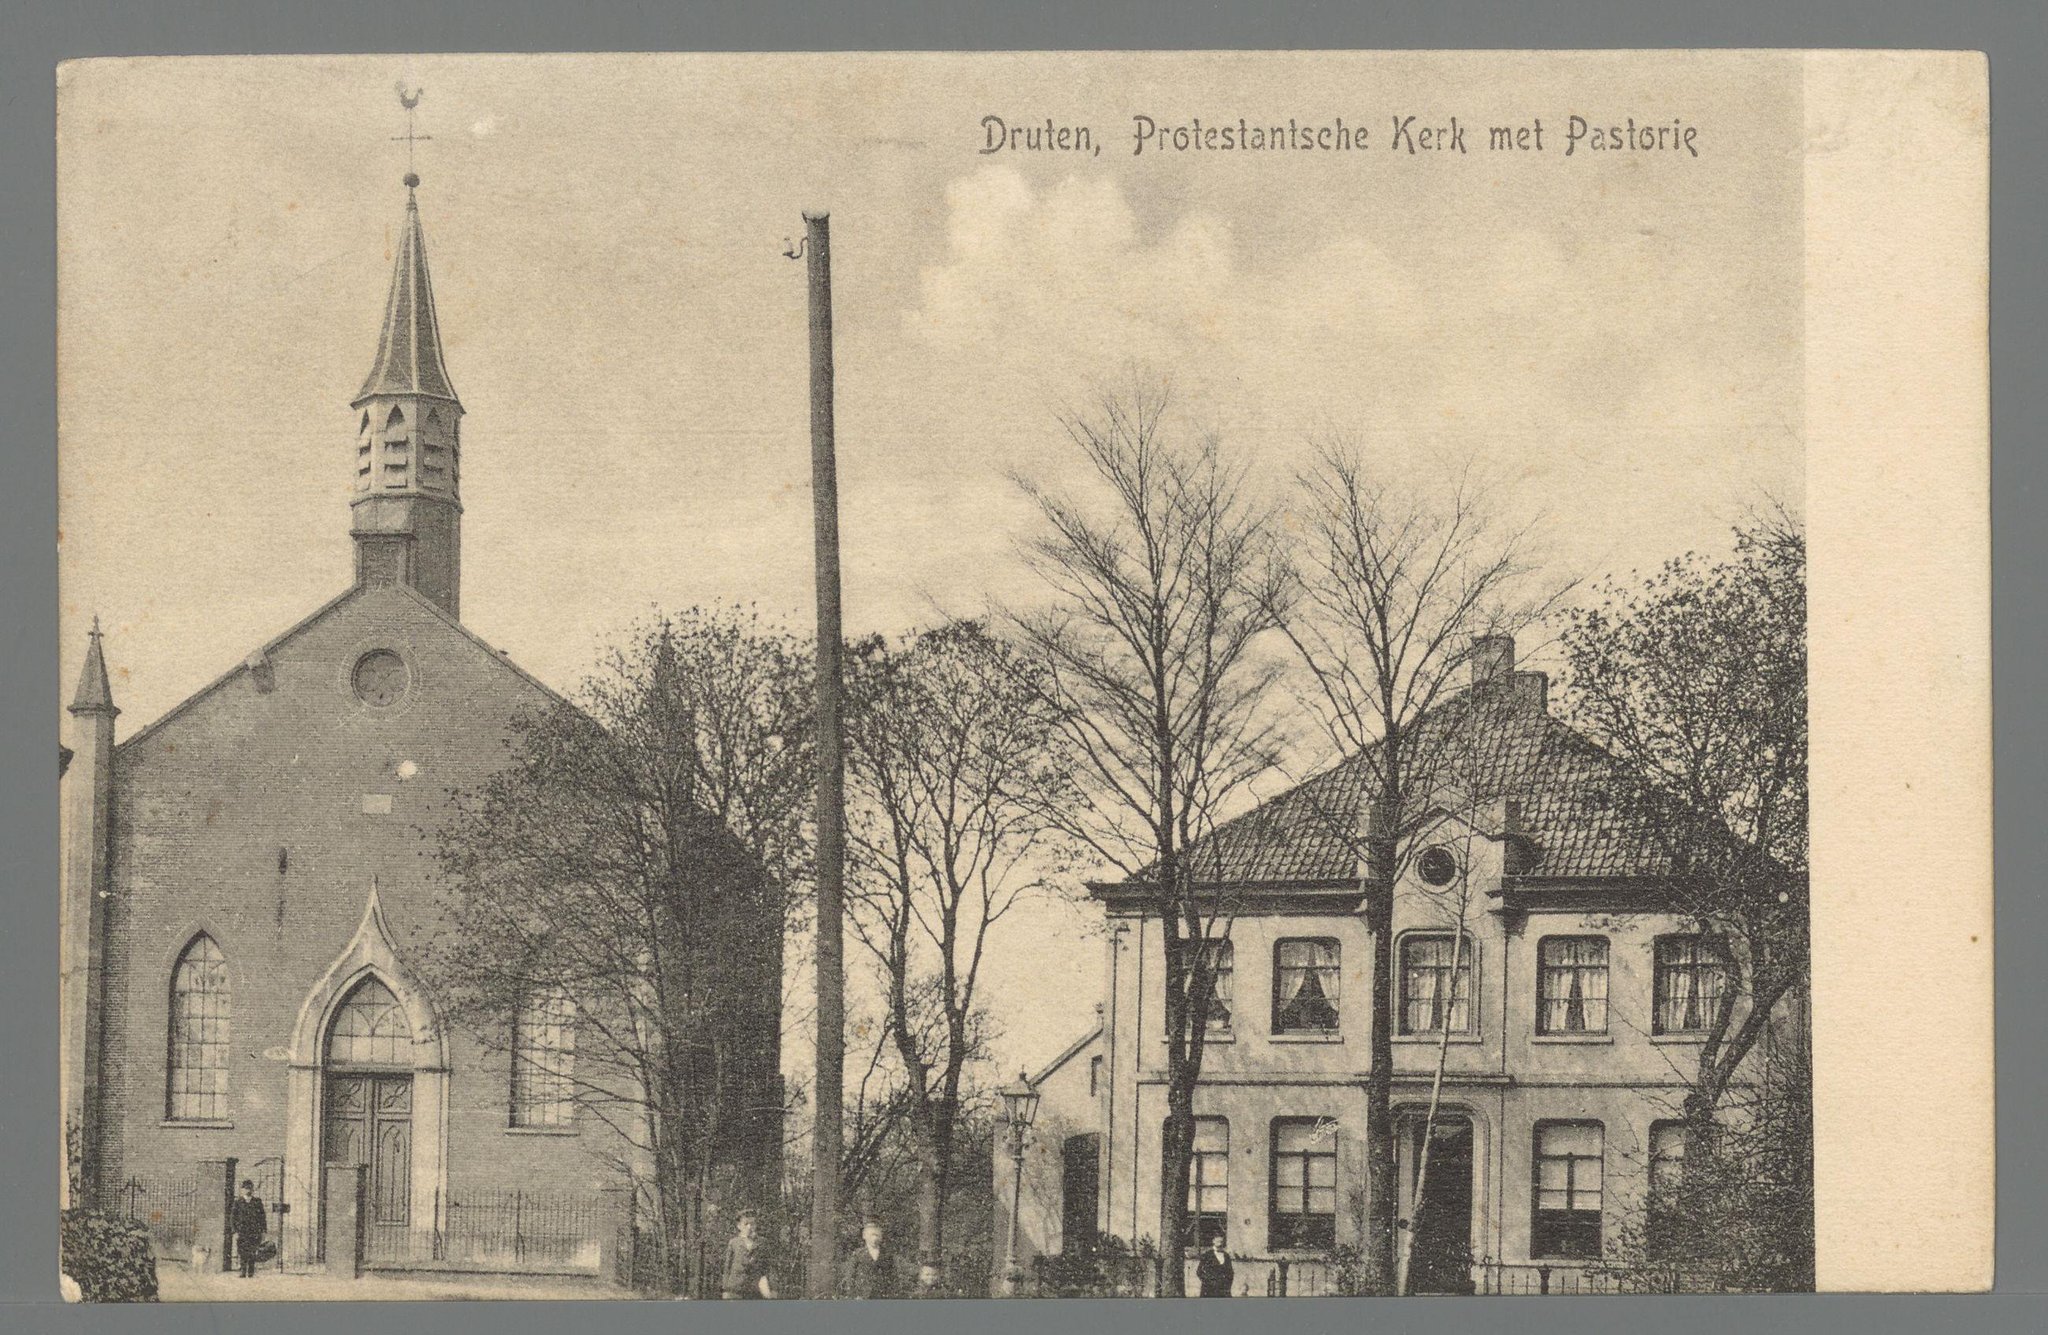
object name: photomechanical print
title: Druten, Protestantsche Kerk met pastorie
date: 1905-1930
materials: cardboard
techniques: photograph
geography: druten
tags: church (exterior)